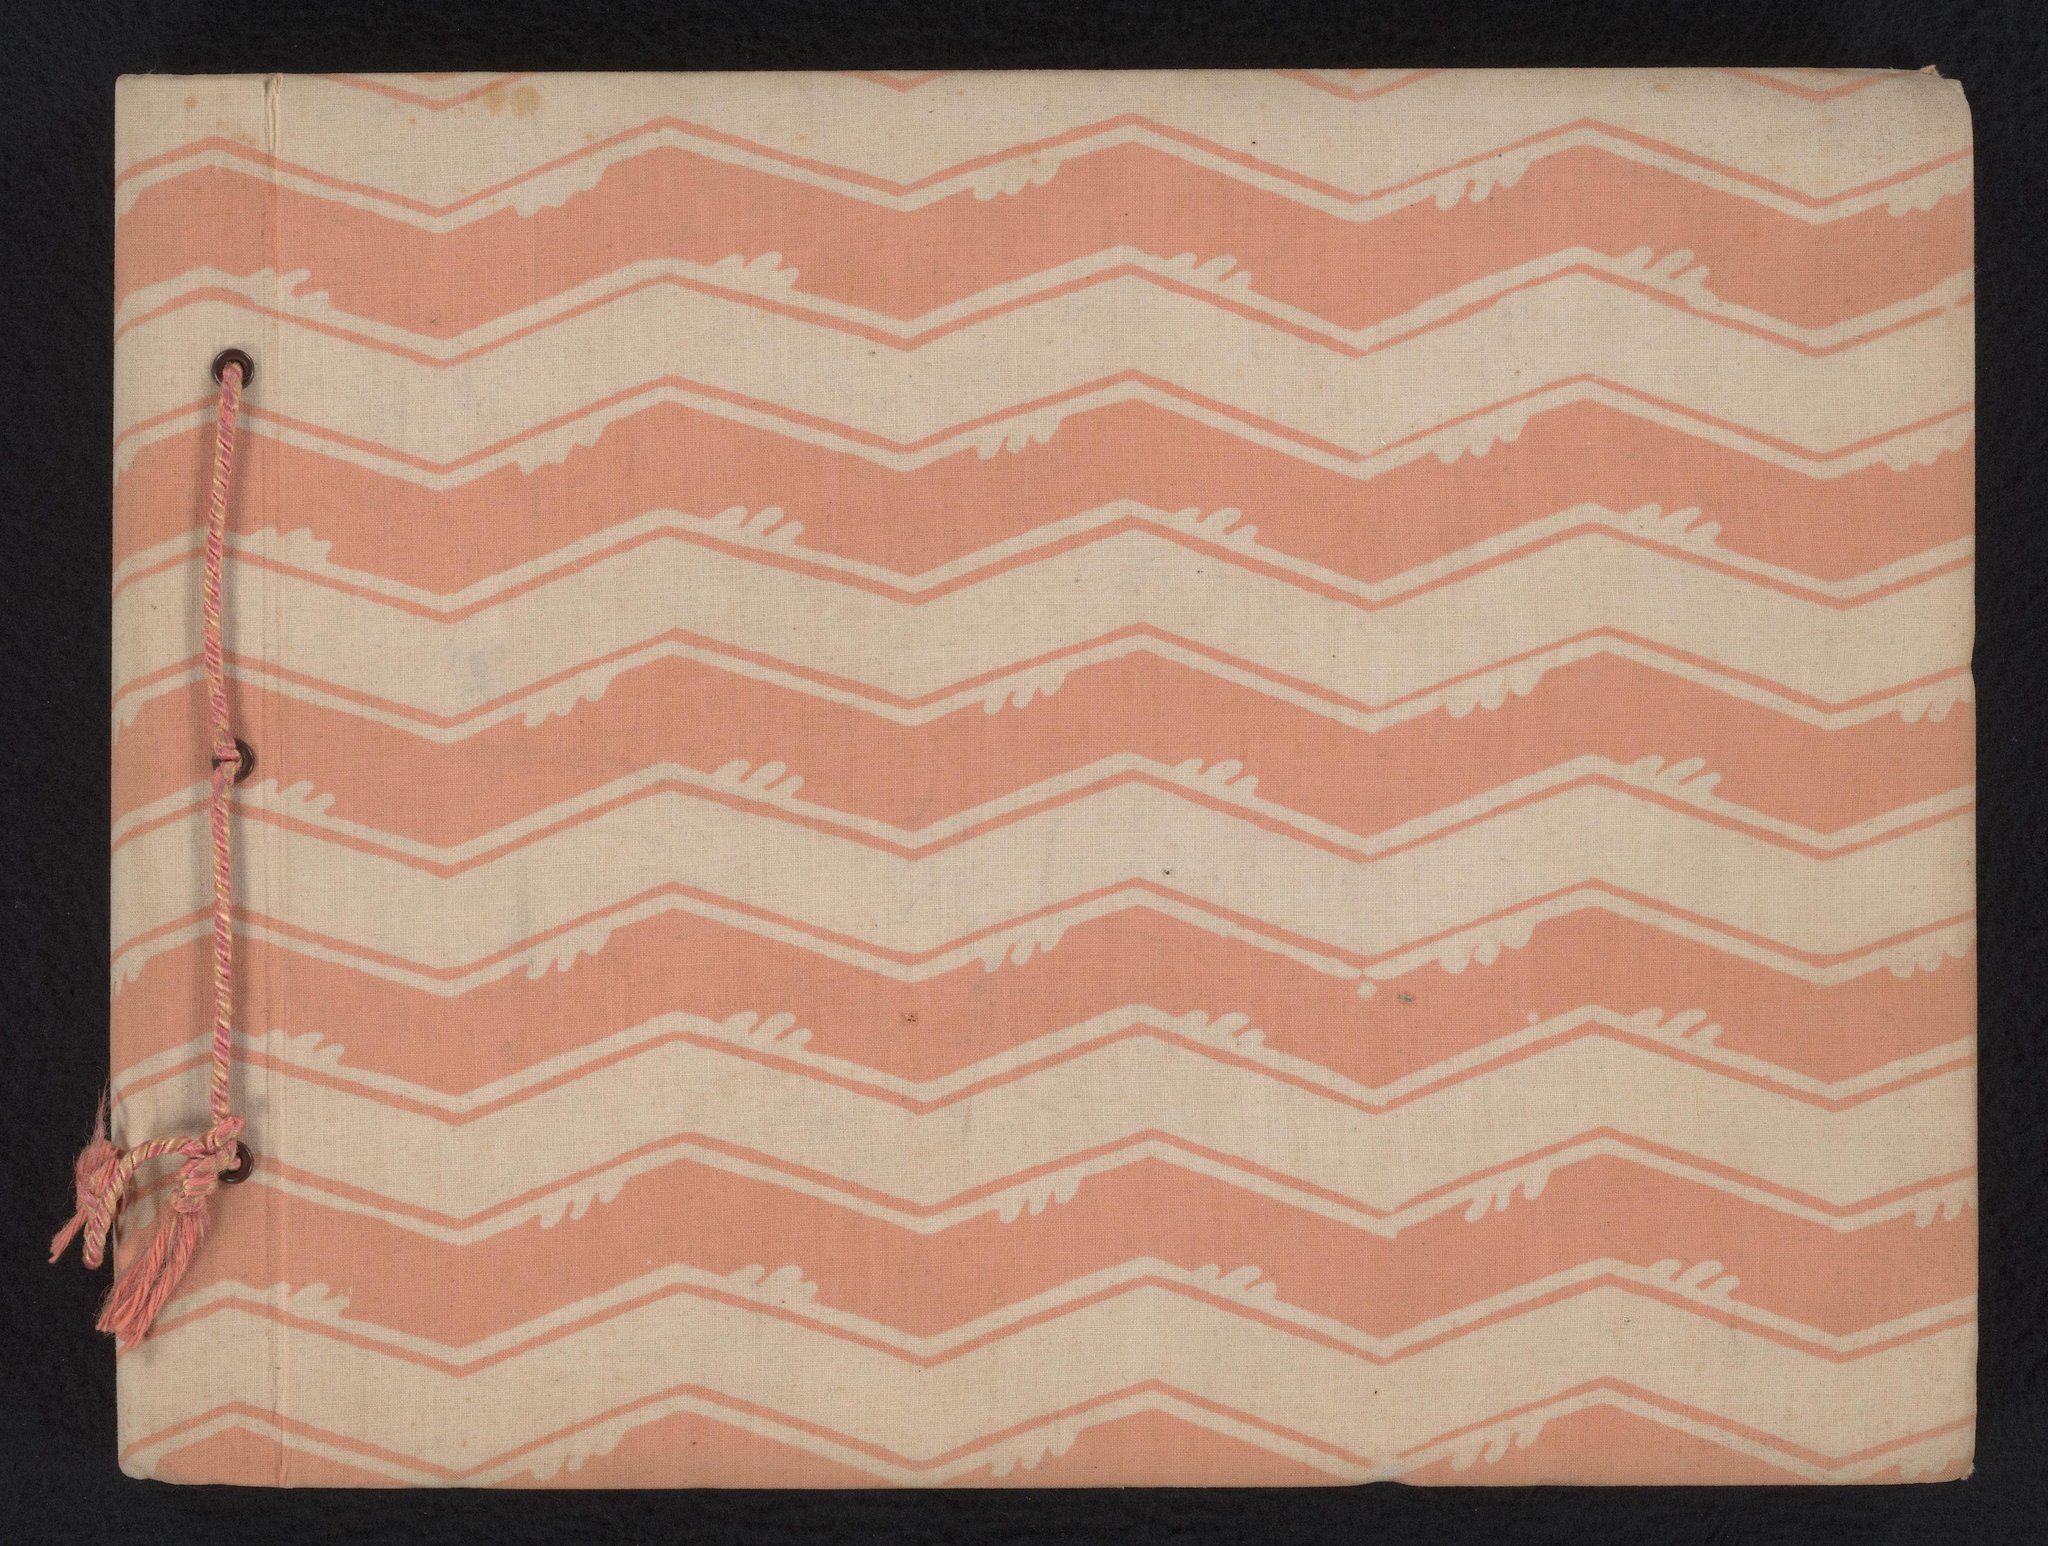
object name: photograph album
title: Fotoalbum met foto's van Isabel Wachenheimer als kind (1928-1931)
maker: else wachenheimer-moos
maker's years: 1895-1944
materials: paper, textile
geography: germany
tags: eugen wachenheimer, else wachenheimer-moos, leiden, isabel wachenheimer-elon, willy moos, josefine moos-levi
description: bijschriften geschreven in het handschrift van Else Wachenheimer-Moos Dit object is onderdeel van de nalatenschap van Isabel Elon-Wachenheimer (1928-2010). Tot haar overlijden behoorde het samen met de andere objecten uit de nalatenschap tot haar privédomein van Isabel Wachenheimer. In die particuliere context zijn deze objecten tezamen en individueel aandenkens - aan de jeugd, ouders en familie van Isabel Wachenheimer vóór en tijdens de Shoah en aan haar leven na de Tweede Wereldoorlog. Isabel Wachenheimer, die van juni 1943 tot mei 1945 gevangen zat in Kamp Westerbork, Theresienstadt, Auschwitz, Lenzing a/d Oberdonau (een buitenkamp van Mauthausen), overleefde de Shoah. Haar ouders – Eugène Wachenheimer en Else Wachenheimer-Moos - werden op 14 oktober 1944 in Auschwitz-Birkenau vermoord.